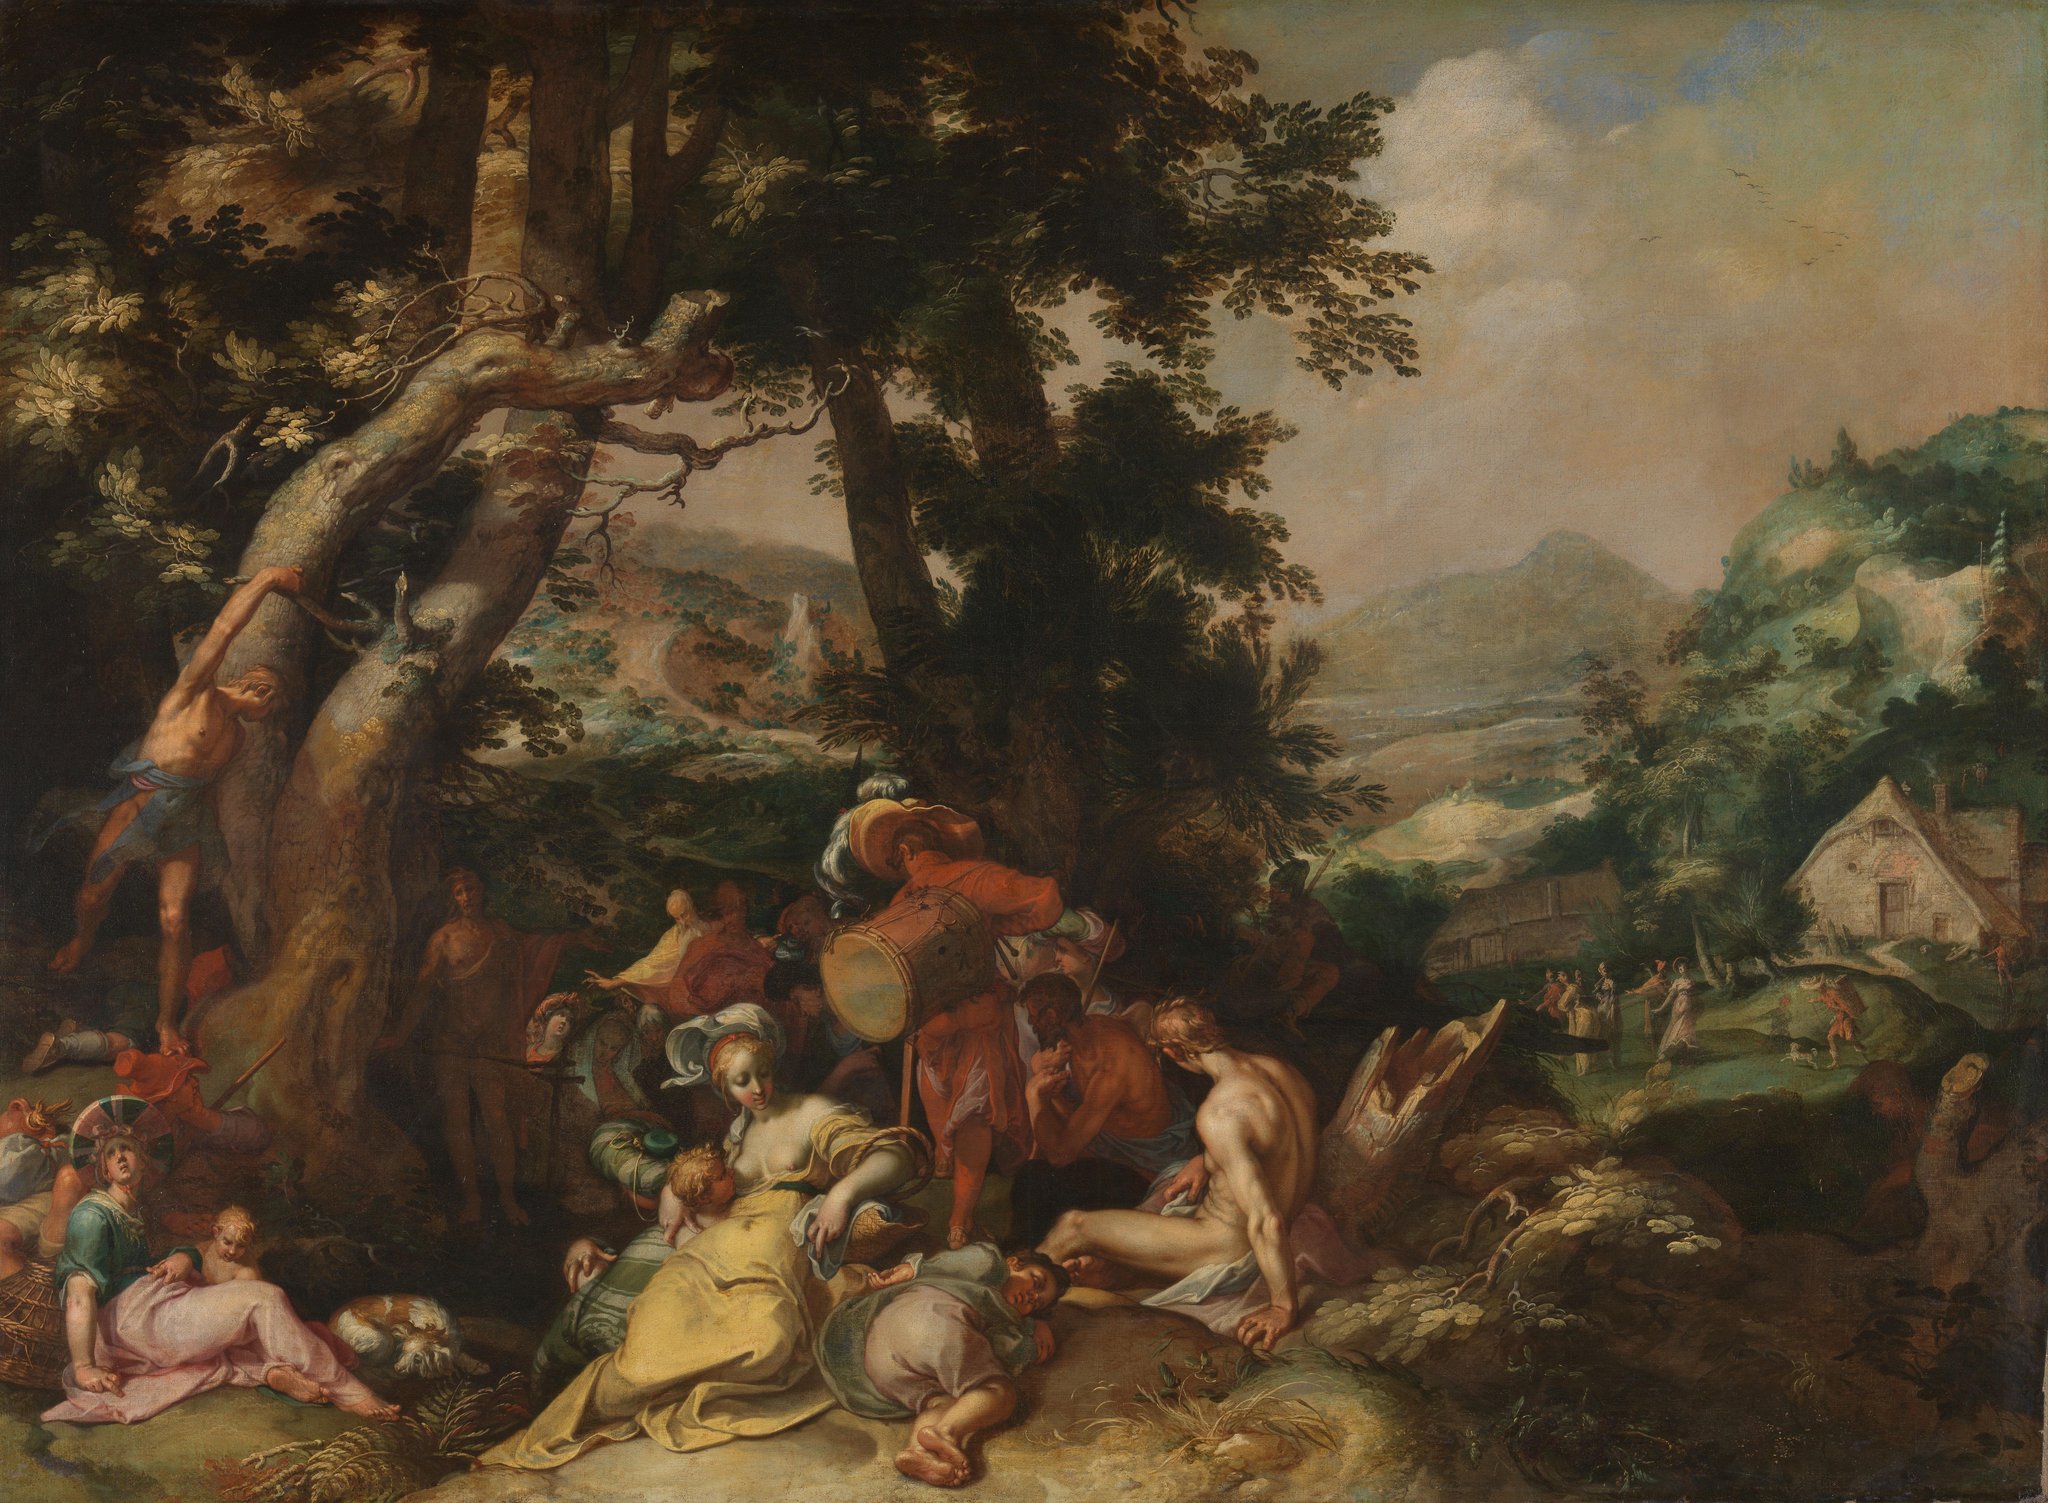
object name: painting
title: The Preaching of St John the Baptist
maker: abraham bloemaert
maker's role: draughtsman, painter, print maker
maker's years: 1566-1651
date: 1590-1610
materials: canvas, oil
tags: nursing, suckling, landscapes in the temperate zone, drum (musical instrument) - cc - out of doors, john the baptist identifies christ as the lamb of god ('ecce agnus dei') (john 1:29, 1:36), john the baptist preaching (perhaps christ among the bystanders)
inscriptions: signature: ‘A.Blommaert’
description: The protagonist in this scene, John the Baptist, the forerunner of Christ, stands partially concealed in the shade of a group of fanciful trees. It is as if Bloemaert wanted to prove that he could paint virtually anything and everything: a mountainous landscape, leafy trees, as well as figures, either nude or clad in exotic colourful gowns and arranged in complicated poses. All of this proves him to be a master of Mannerism.